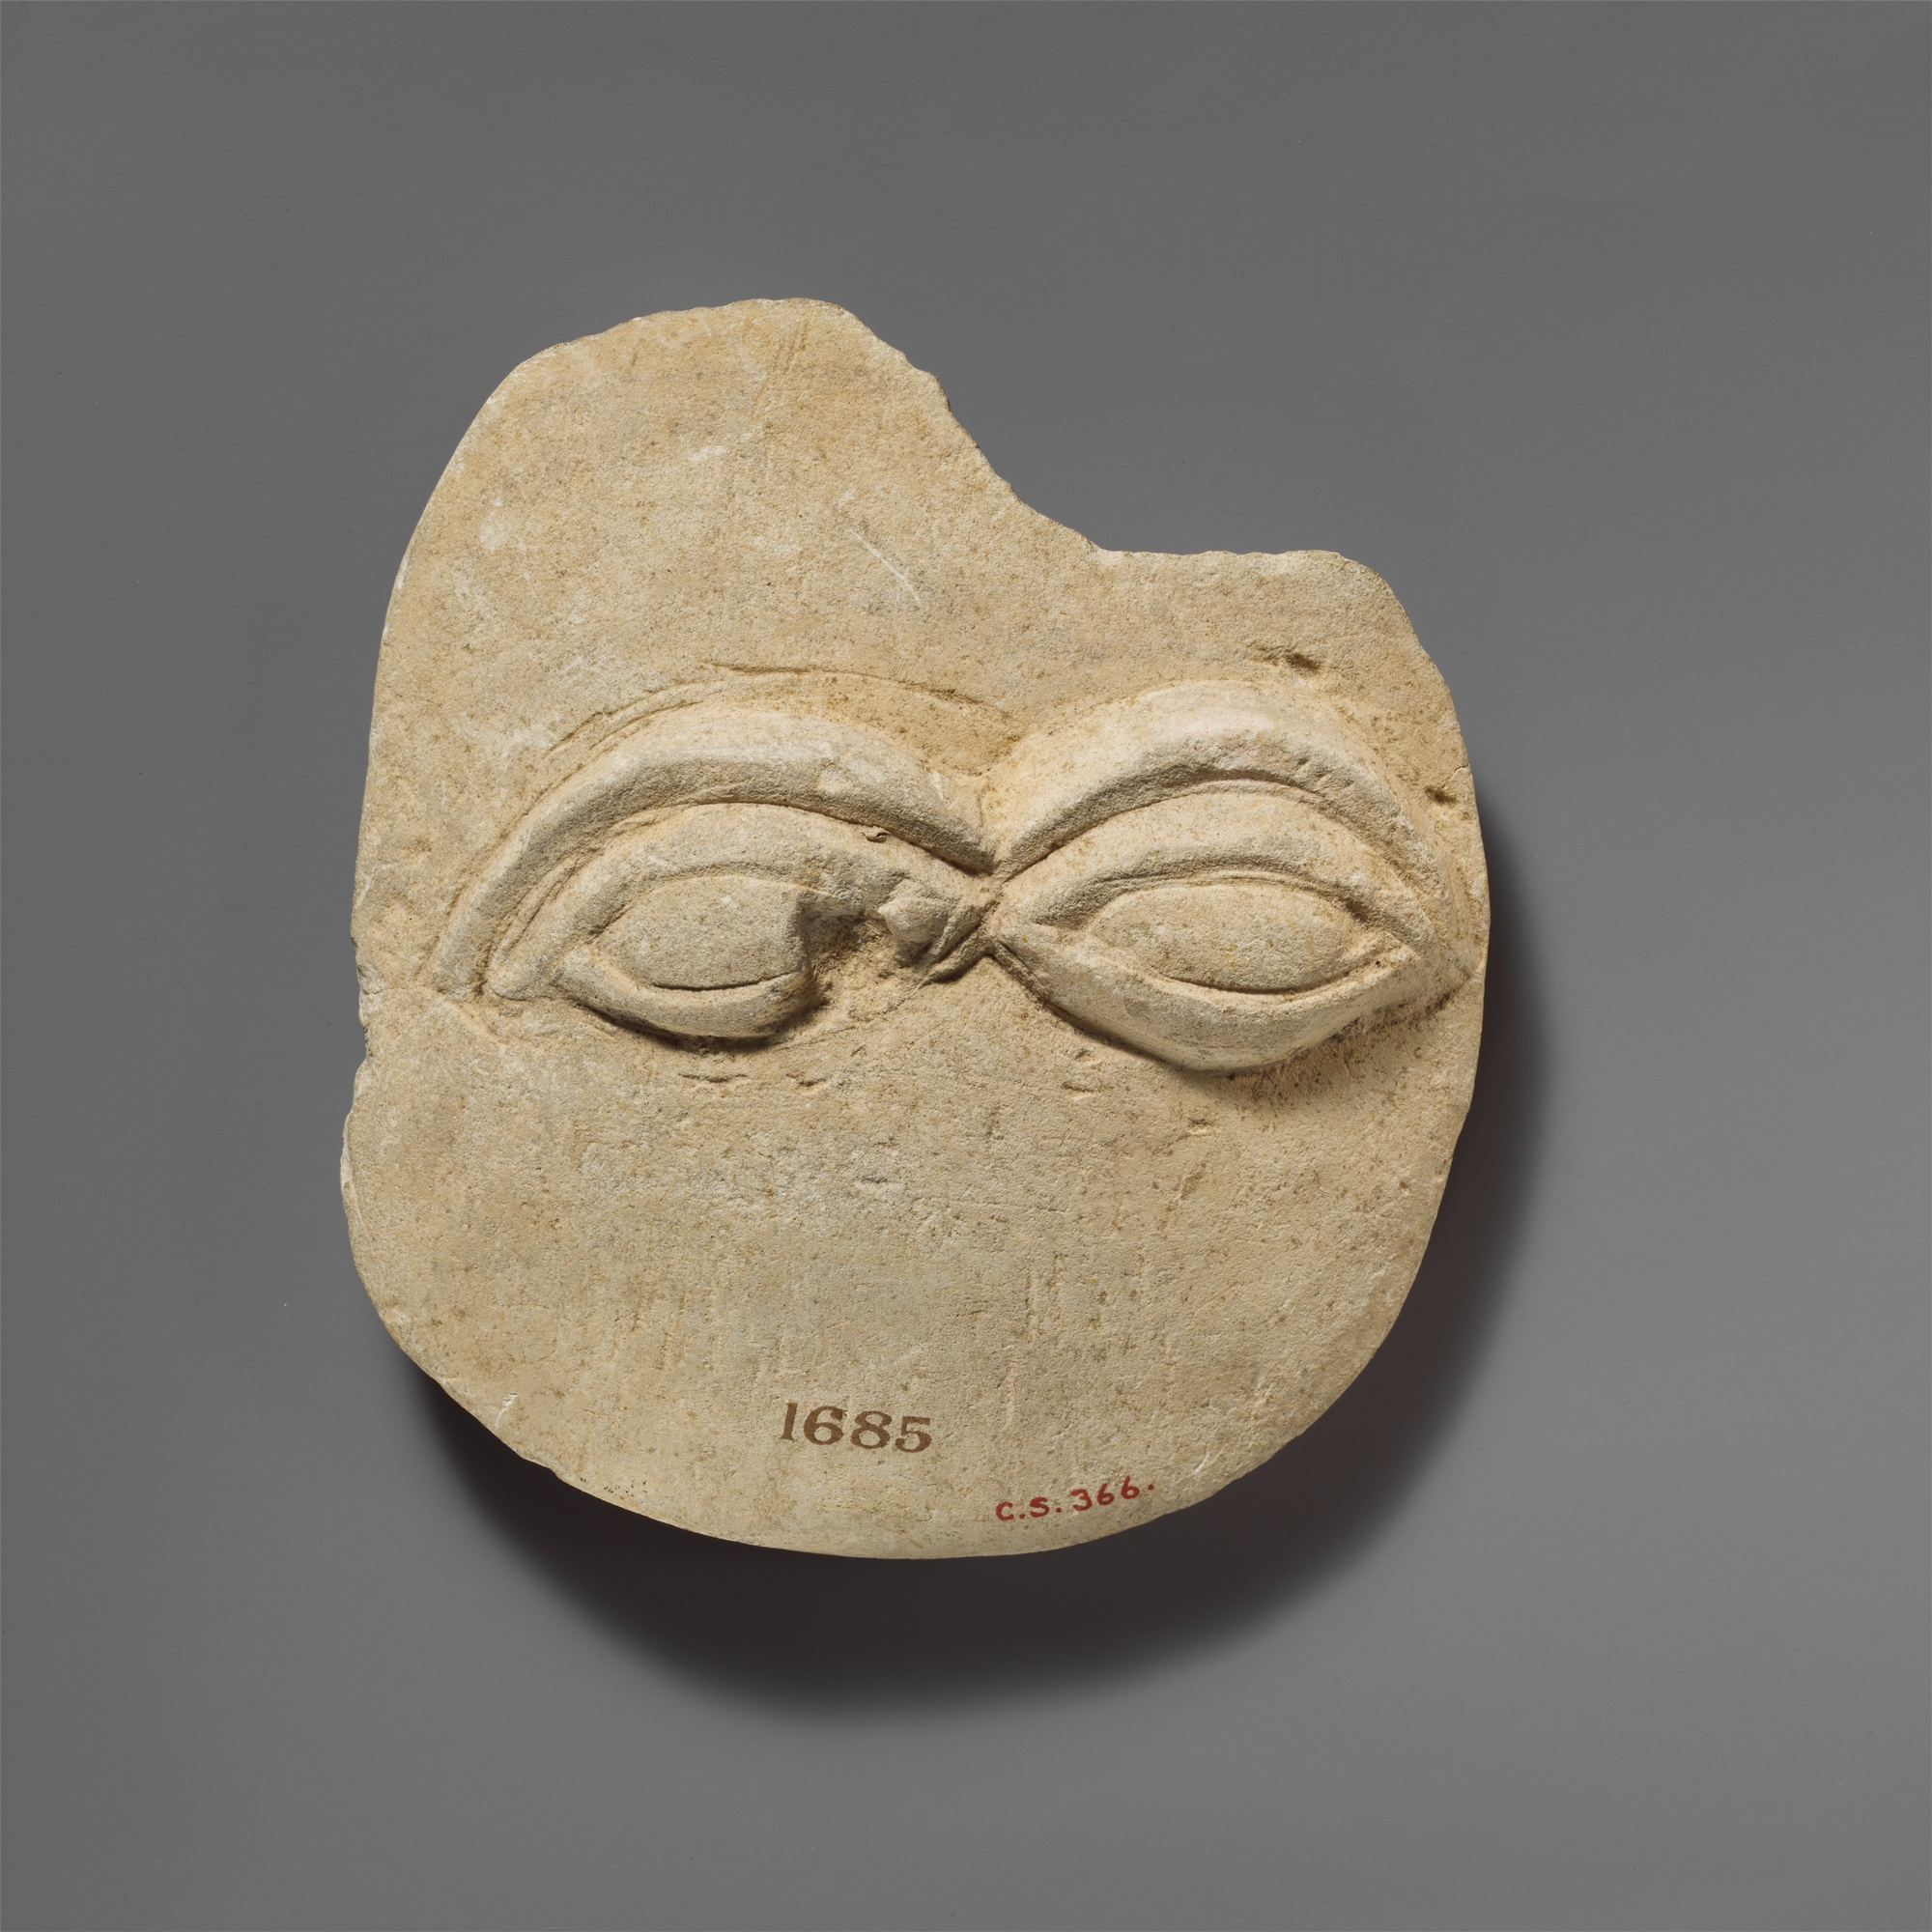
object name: eye, votive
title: Limestone plaque with two eyes in relief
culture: cypriot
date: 480-310 BCE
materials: limestone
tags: eyes